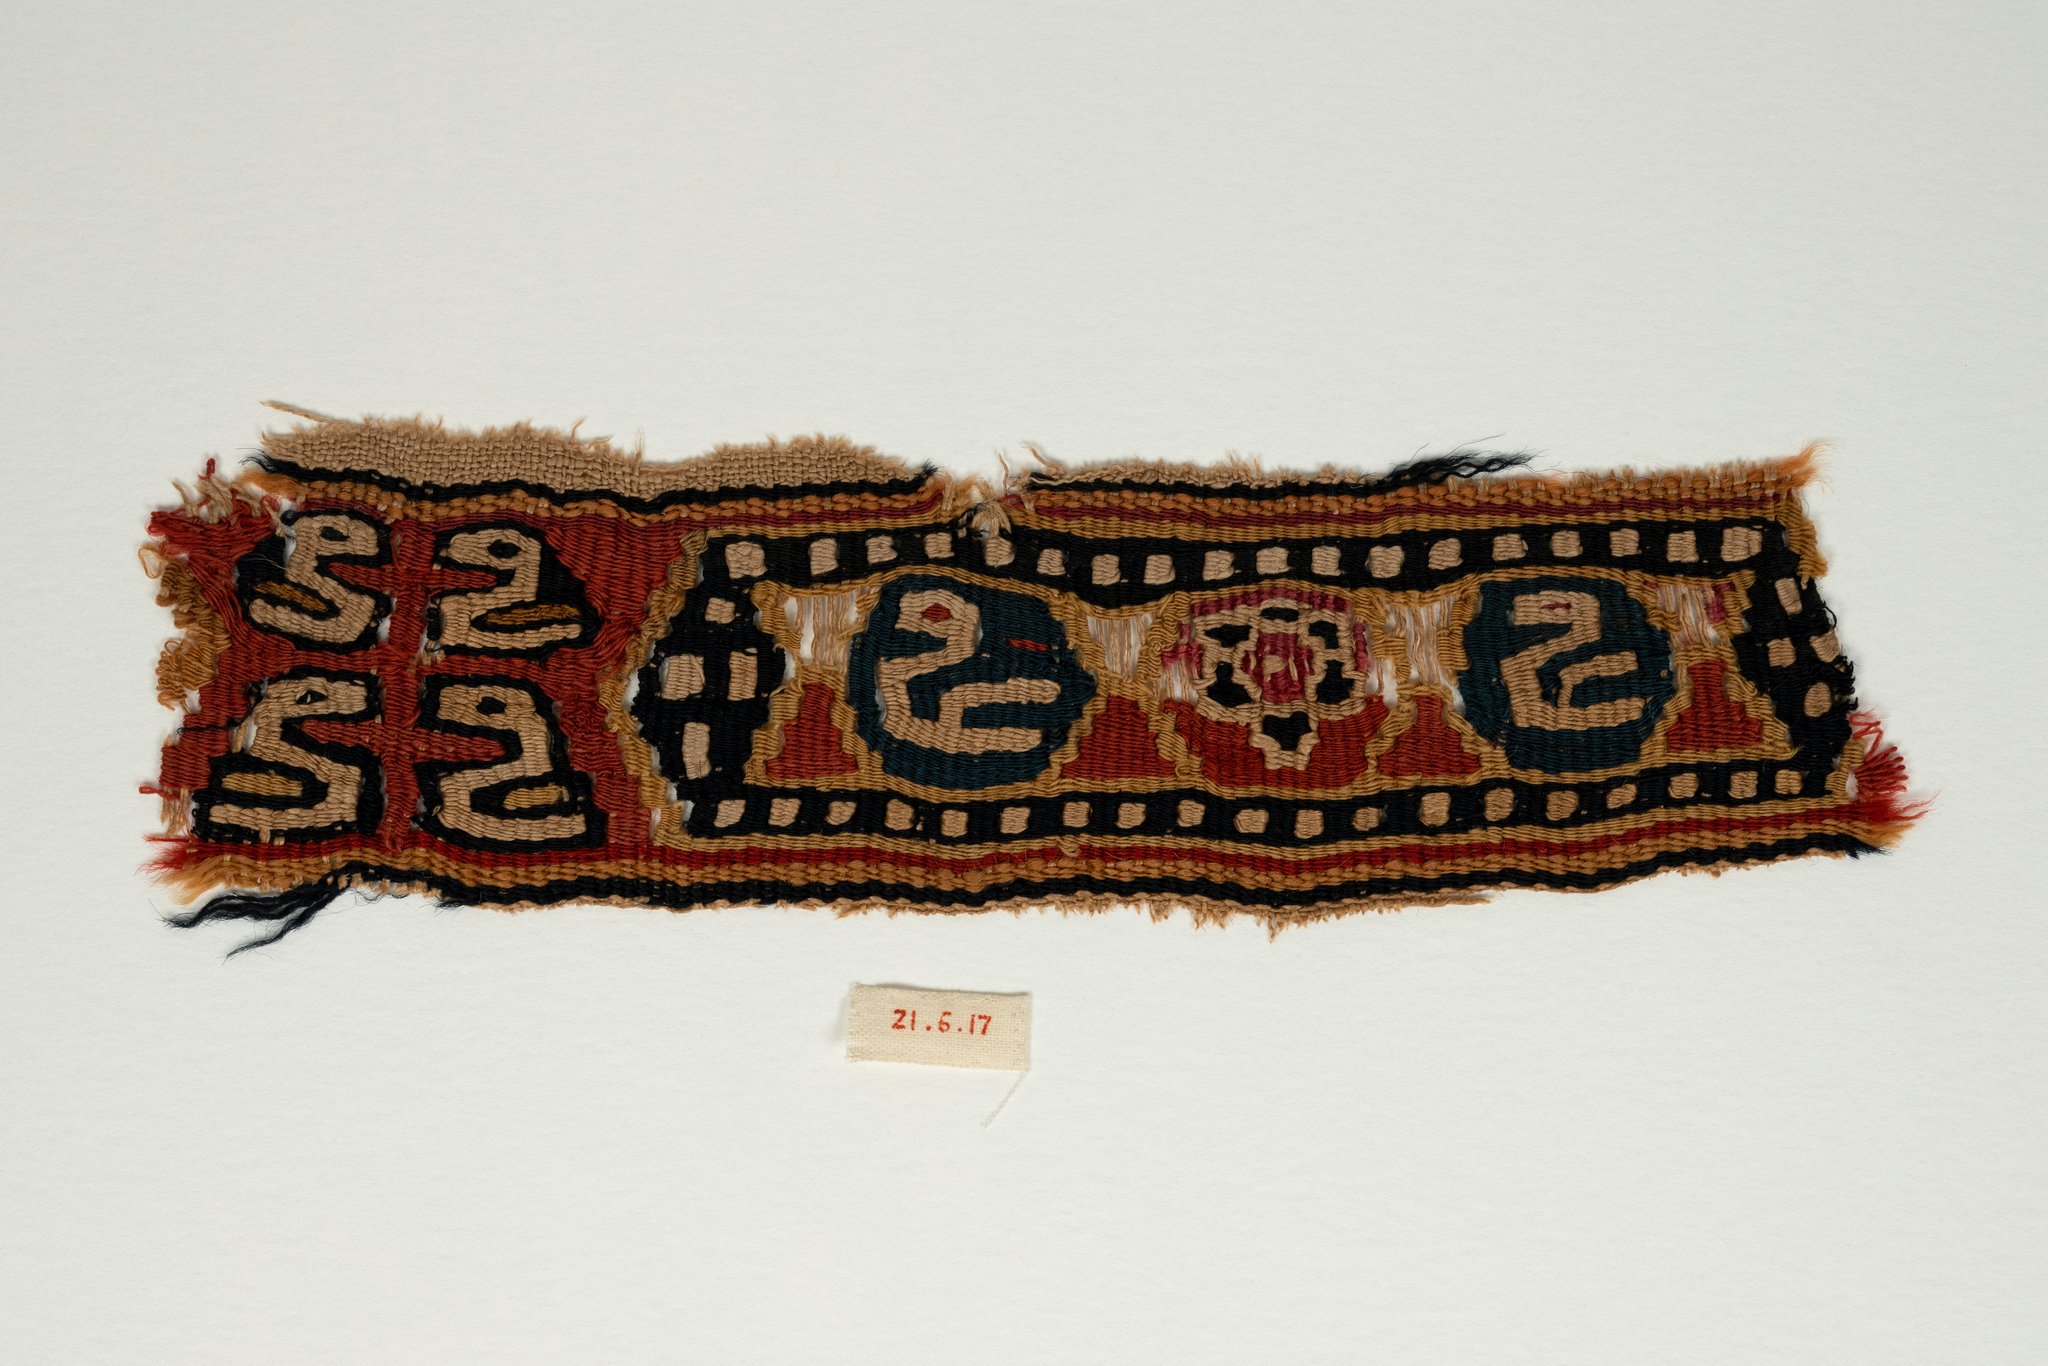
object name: band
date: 501-700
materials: linen, wool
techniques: tapestry, weave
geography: egypt